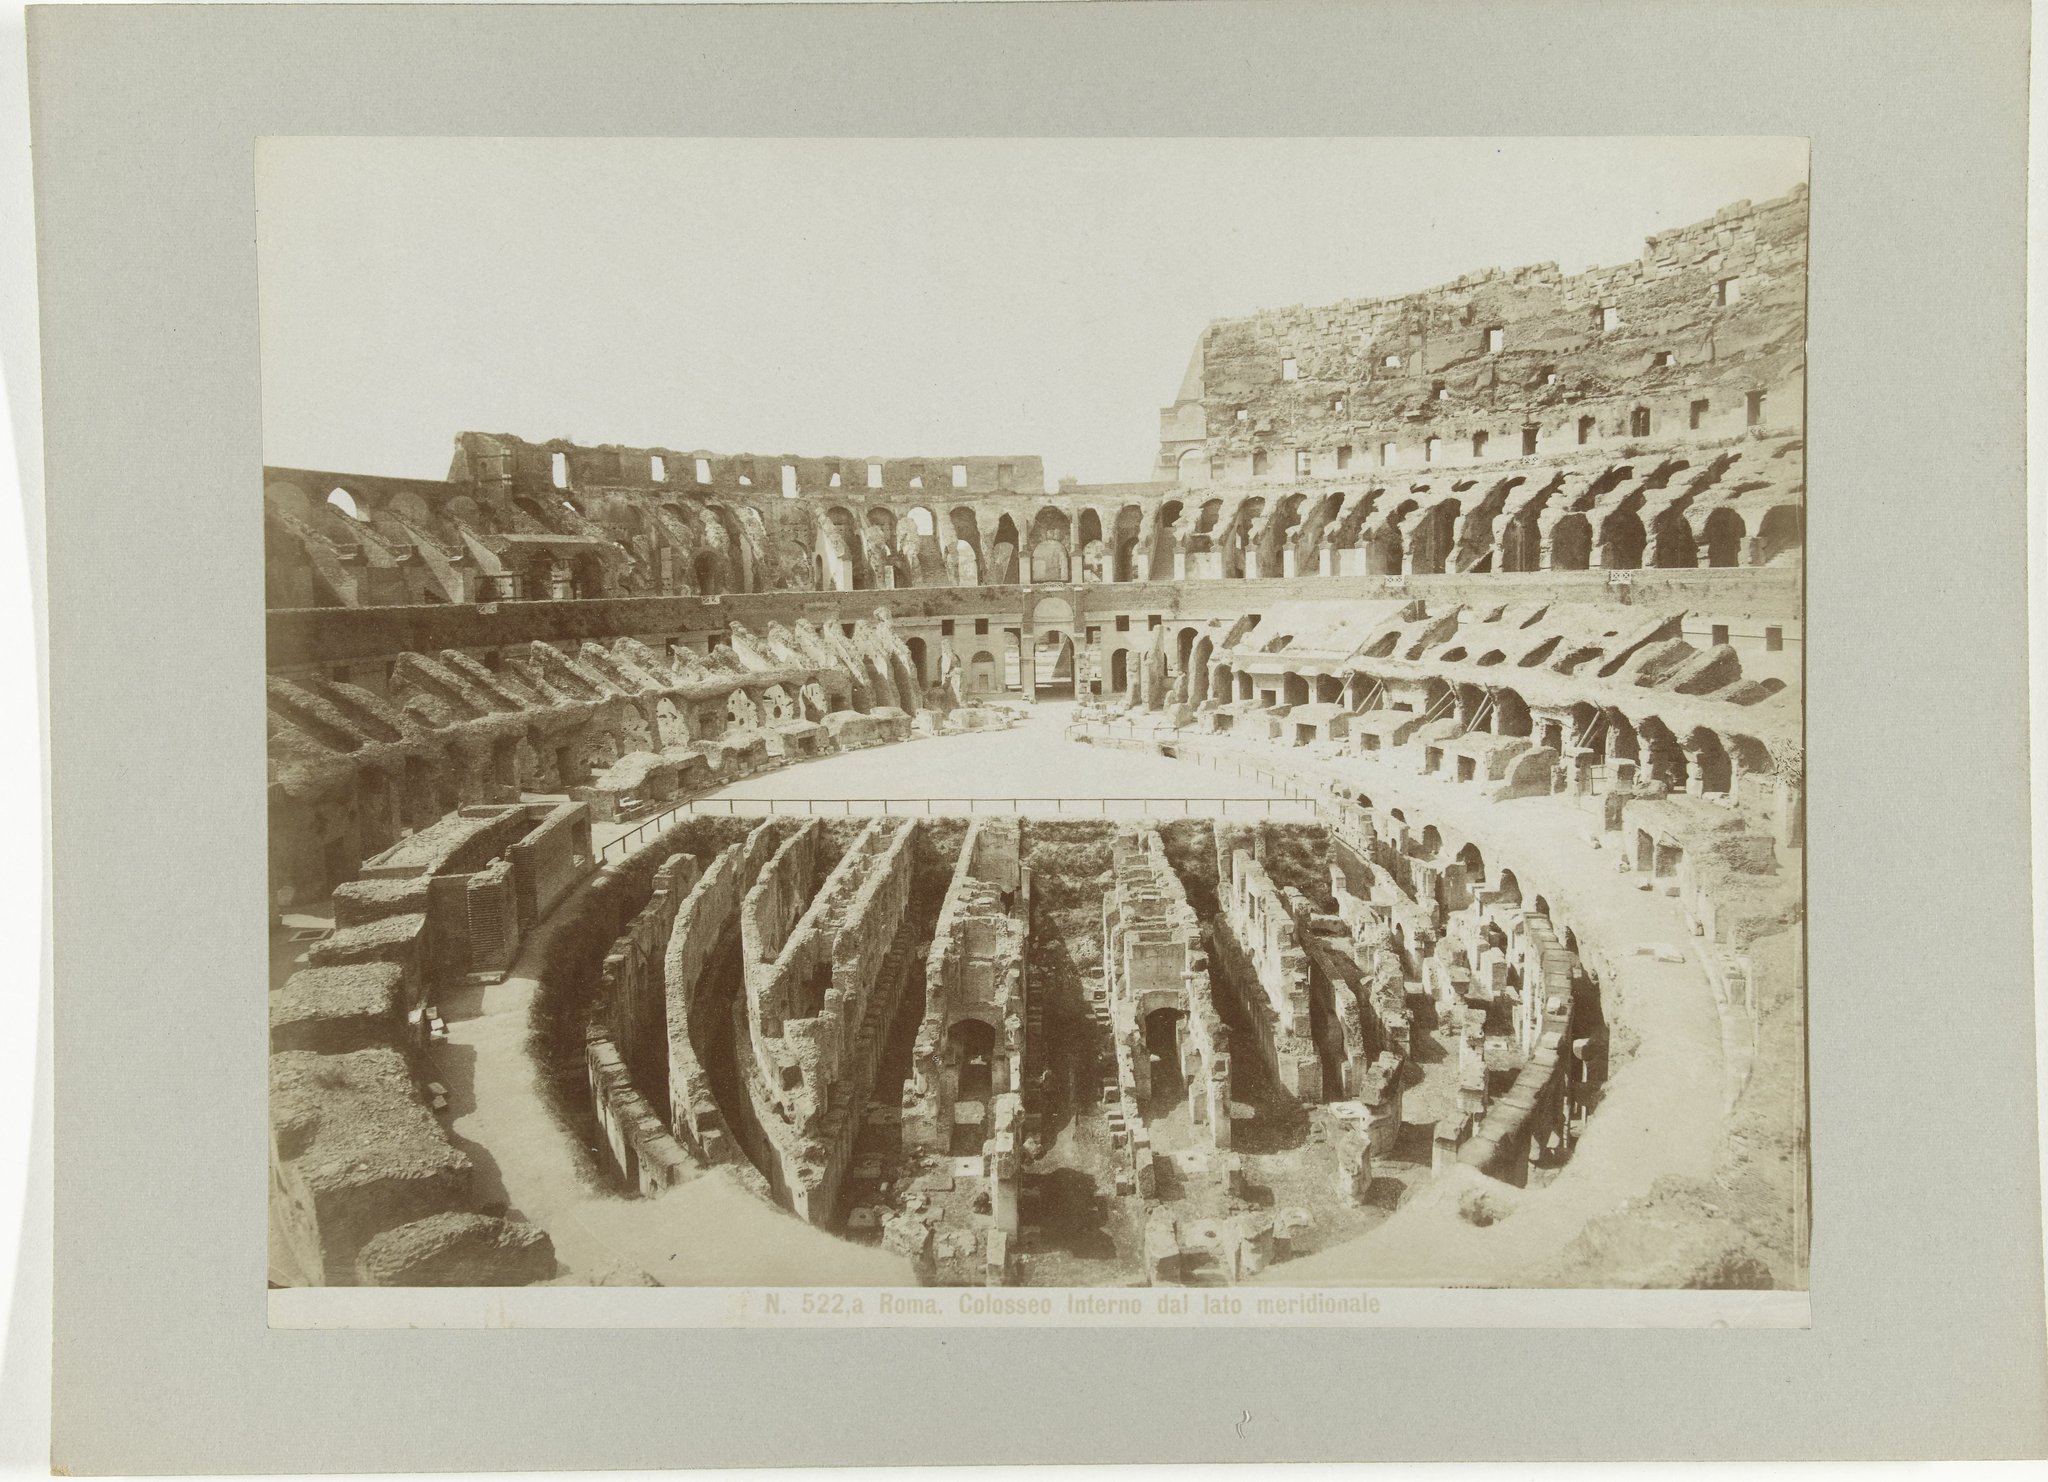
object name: photograph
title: Binnenkant van het Colosseum te Rome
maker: Anonymous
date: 1880-1904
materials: cardboard, paper, photographic support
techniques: albumen print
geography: rome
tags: colosseum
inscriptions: number: ‘21.’